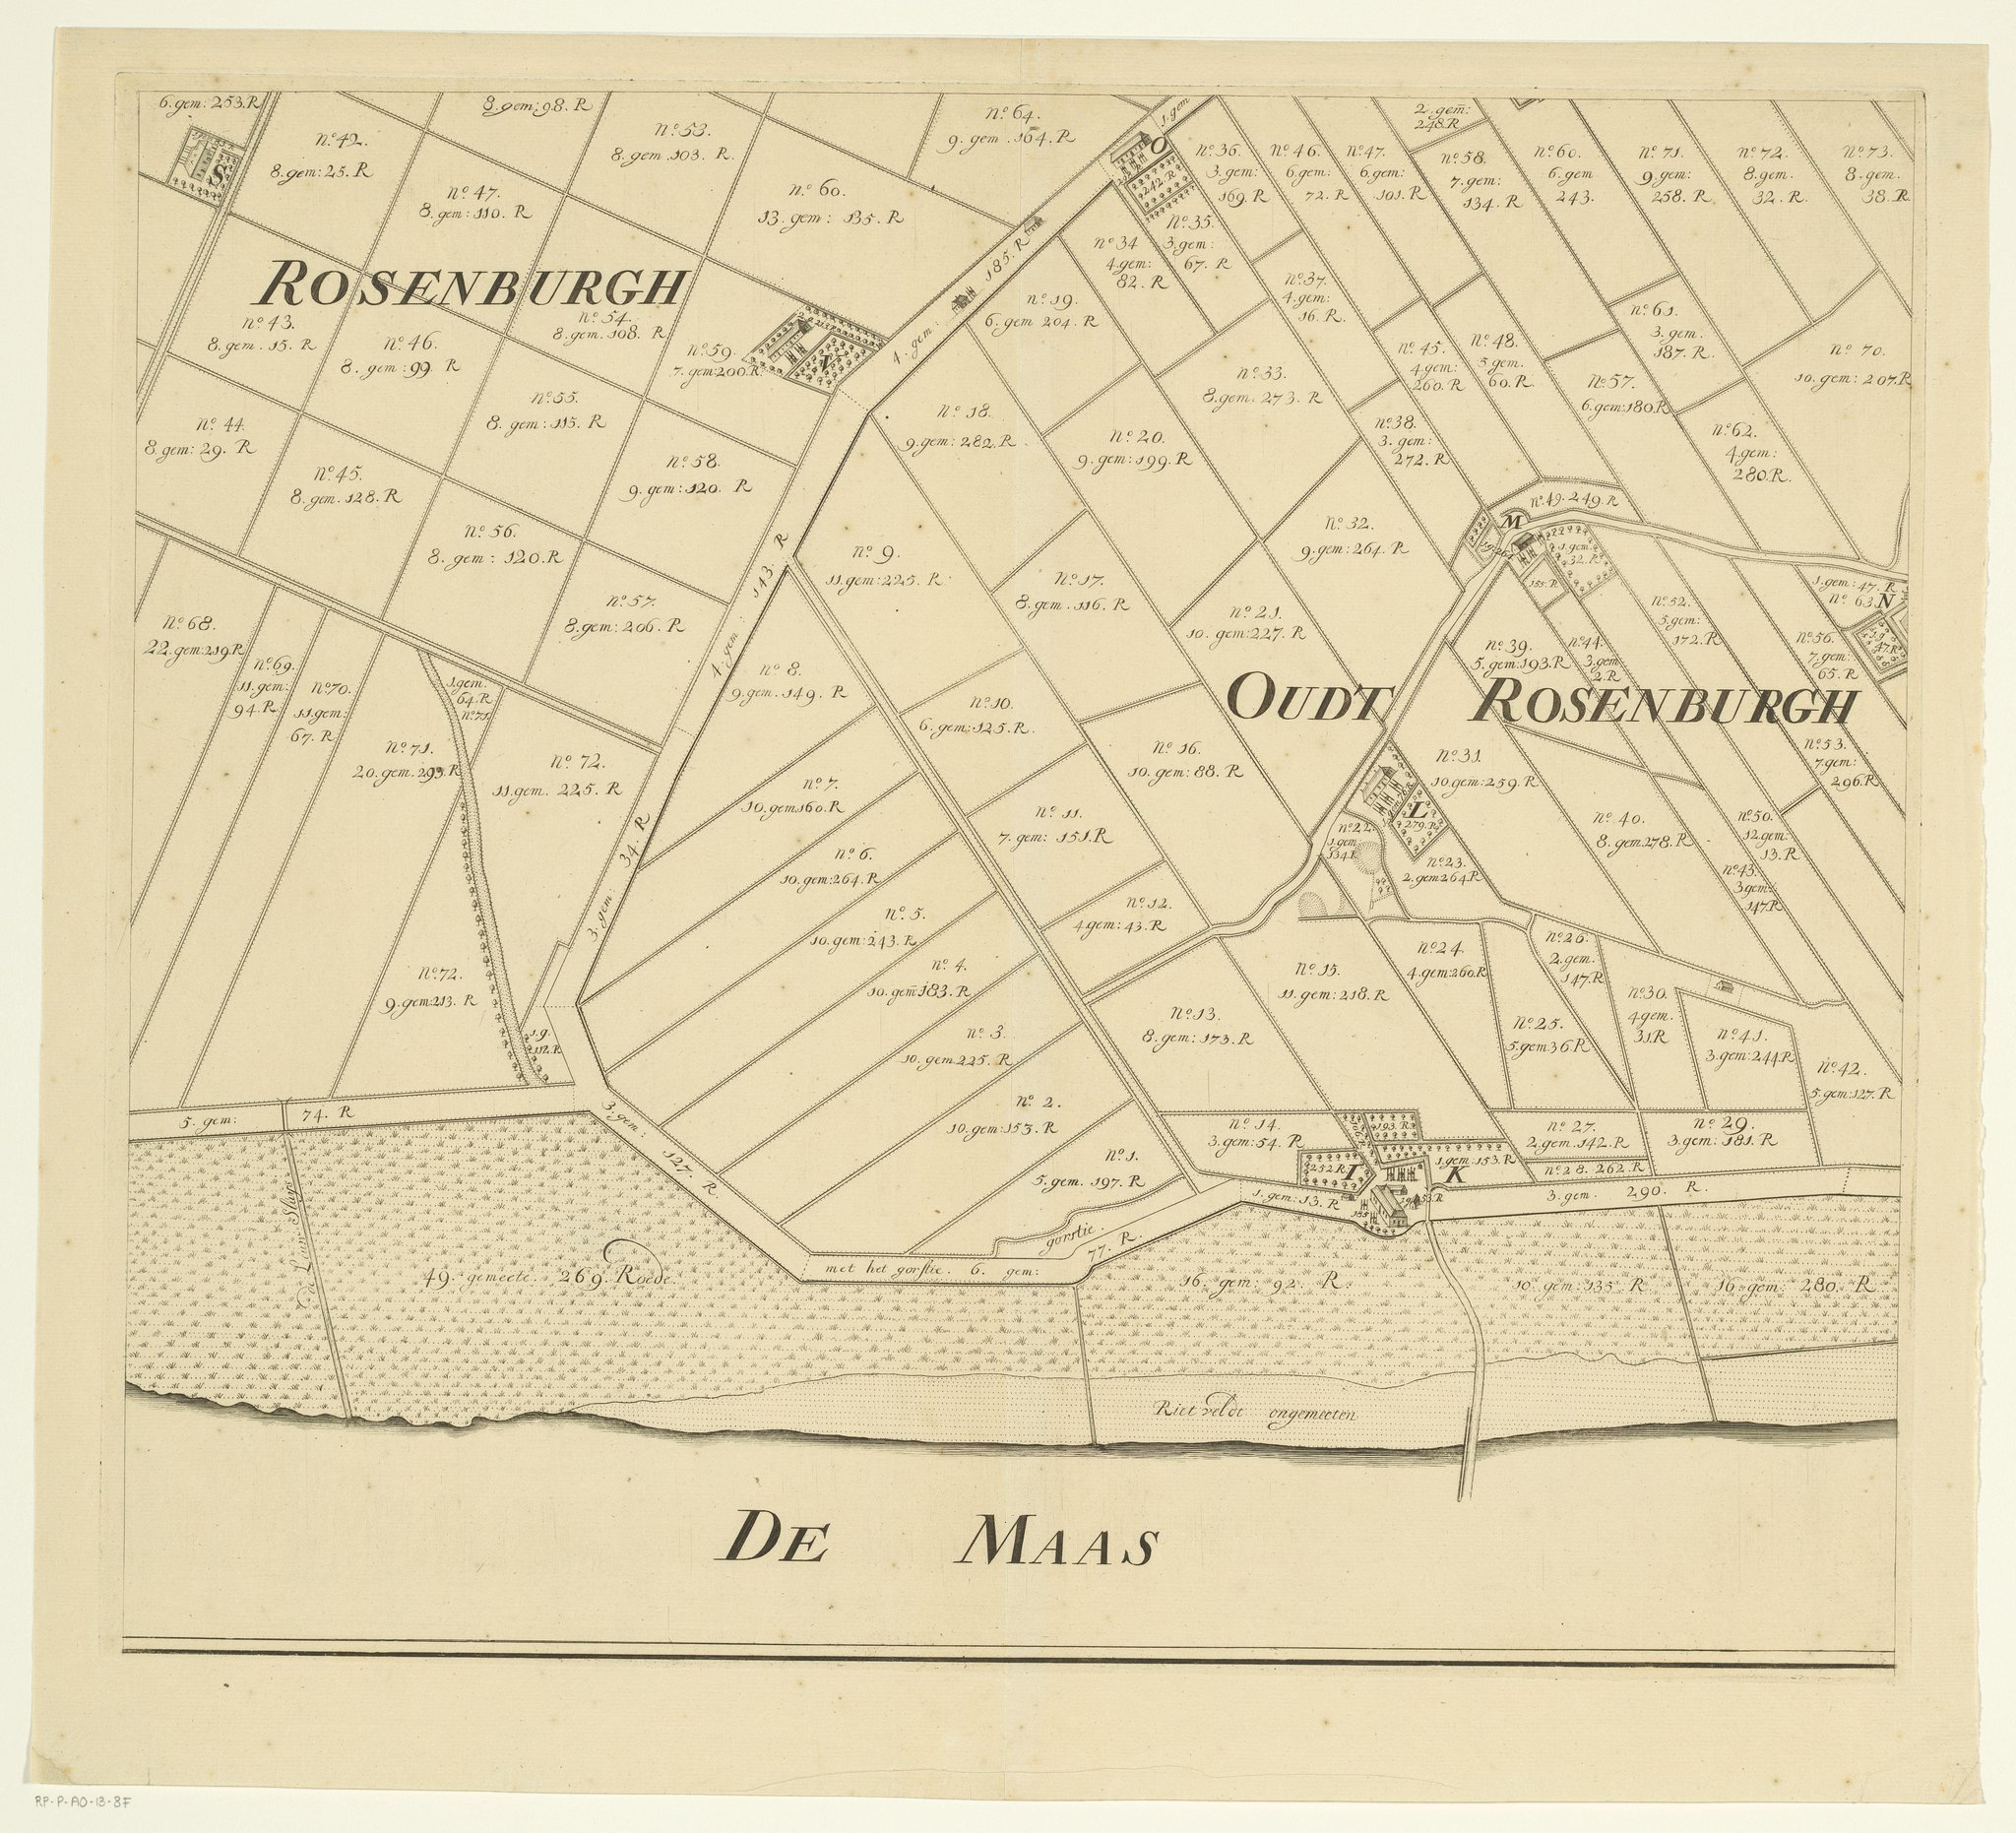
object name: print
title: Kaart van het eiland Rozenburg (tweede deel van onder)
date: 1727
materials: paper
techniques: engraving, etching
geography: the hague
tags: maps of separate countries or regions, polder, reclaimed land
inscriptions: collector's mark: Lugt 2228, collector's mark: Lugt 195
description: Deel (tweede van onder) van een kaart van het eiland Rozenburg, bestaande uit acht delen.